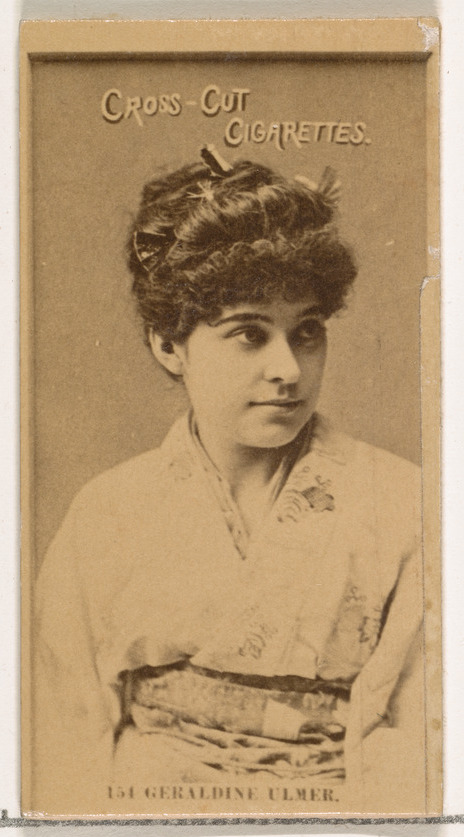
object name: print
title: Card Number 151, Geraldine Ulmer, from the Actors and Actresses series (N145-2) issued by Duke Sons & Co. to promote Cross Cut Cigarettes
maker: w. duke, sons & co.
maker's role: publisher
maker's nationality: american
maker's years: 1870-1920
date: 1880-1889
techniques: albumen silver print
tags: portraits,women,actresses